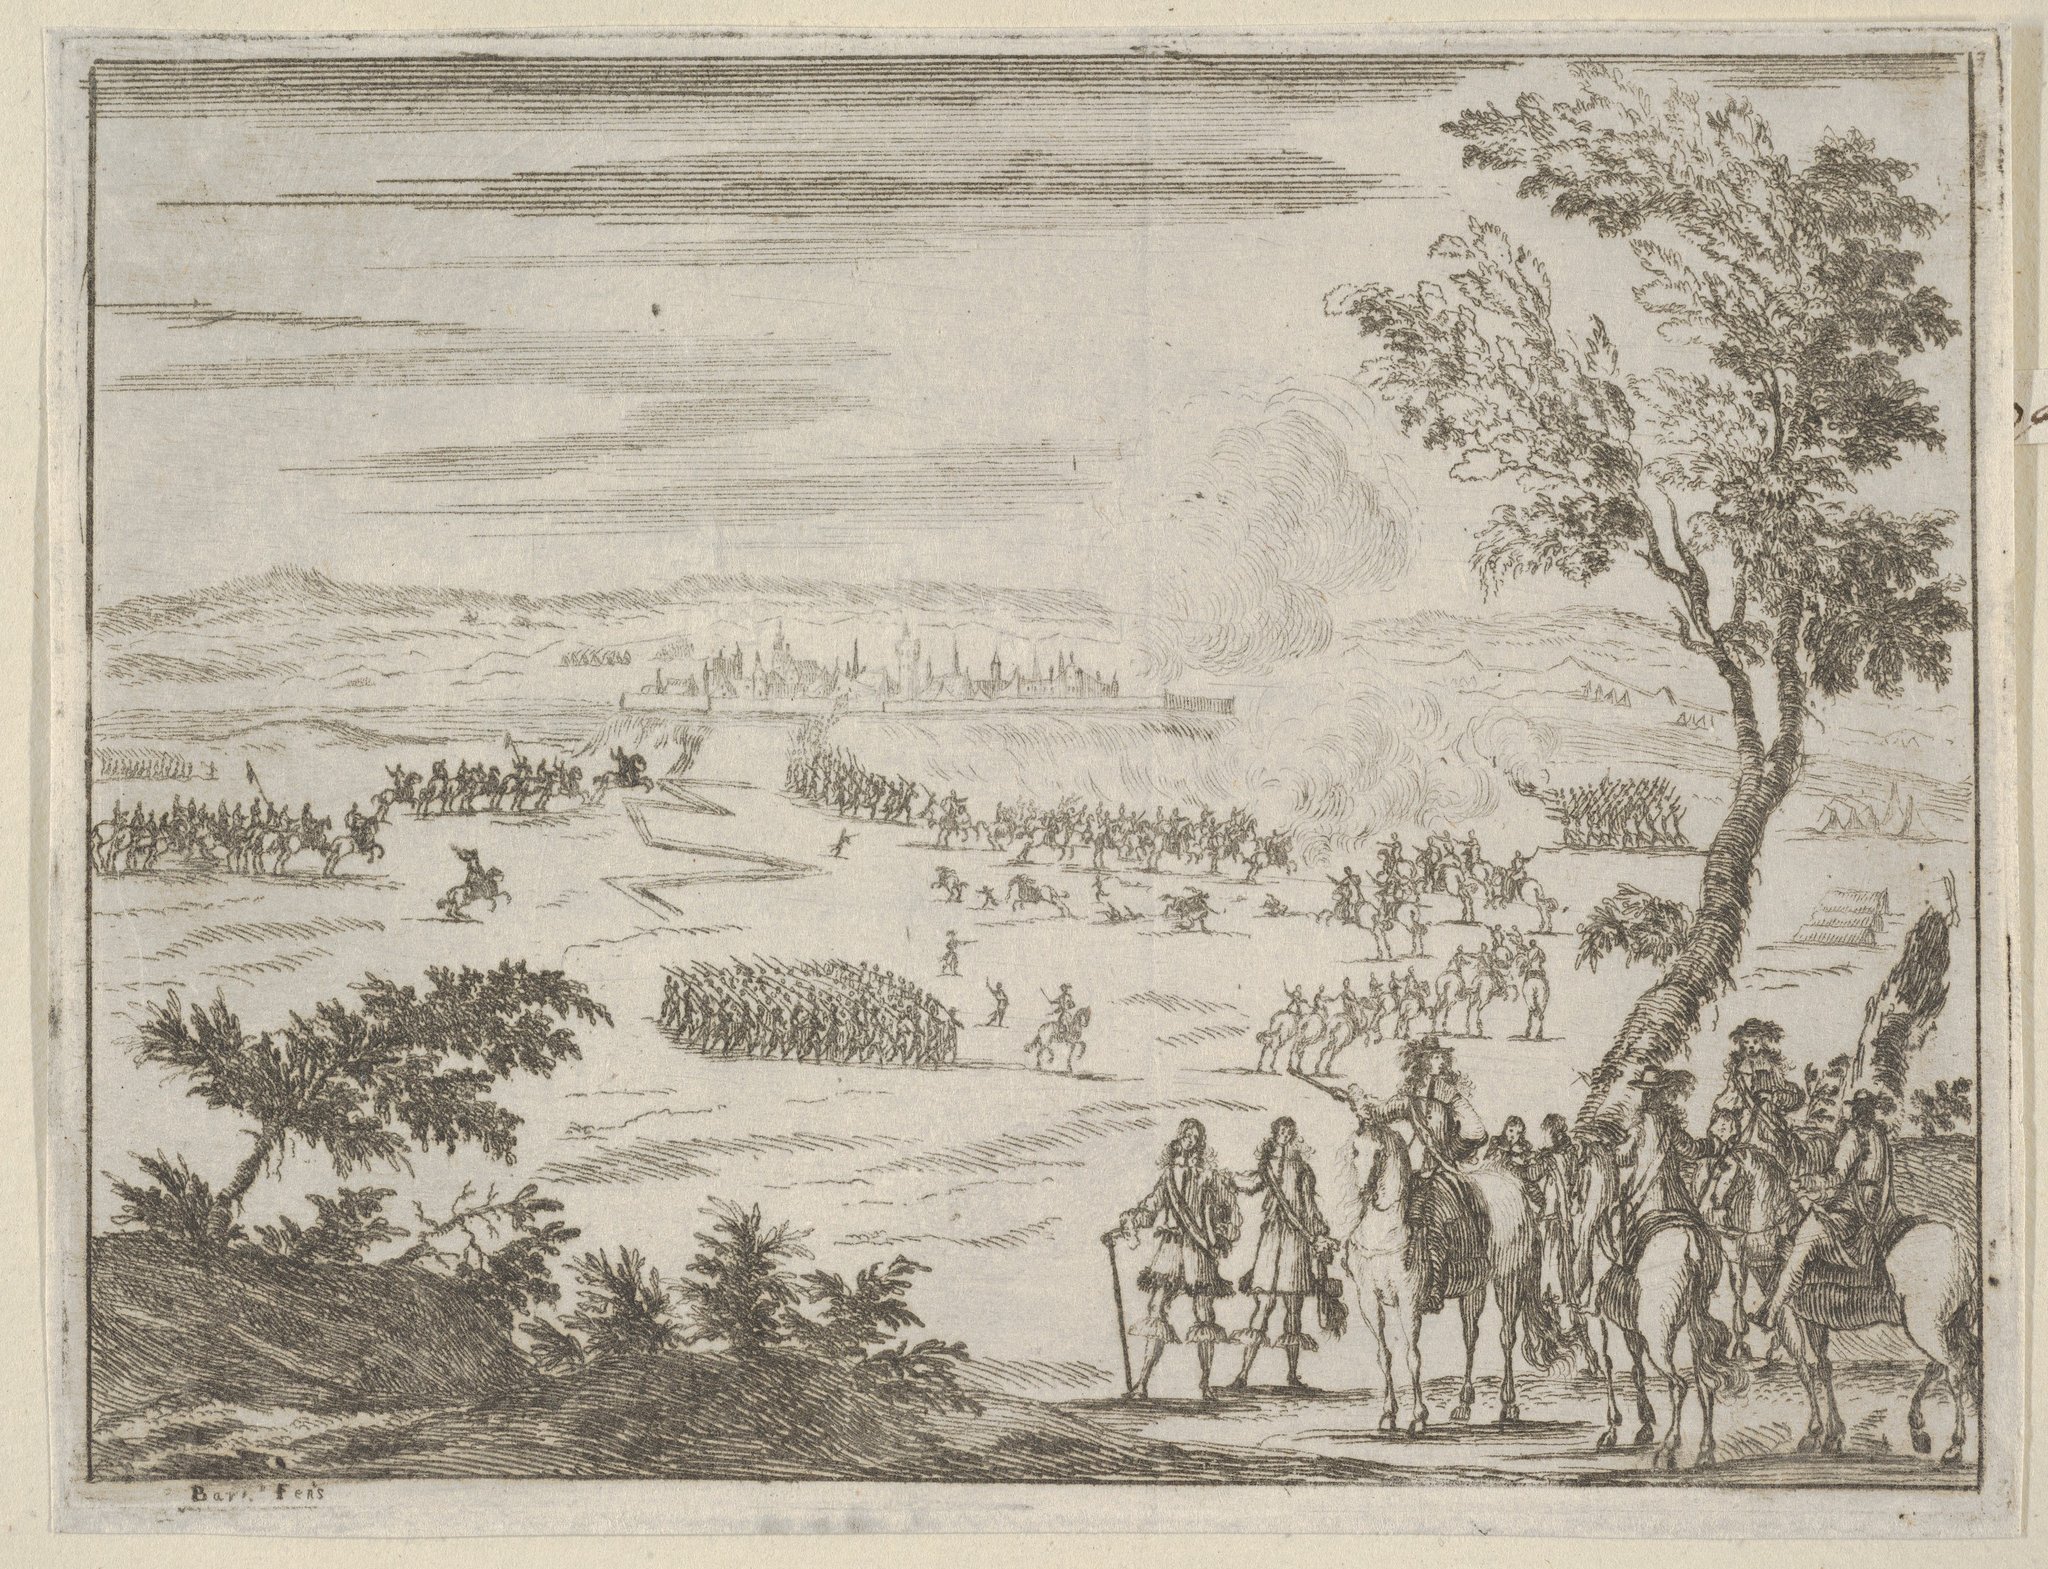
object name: print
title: Francesco I d'Este and the French Army Besiege Valenza, which has Been Taken by the Spanish, and by Persisting with Intrepid Courage, Succeeds in the Endeavor, from "L'Idea di un Principe ed Eroe Cristiano in Francesco I d'Este, di Modena e Reggio Duca VIII [...]"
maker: bartolomeo fenice (fénis)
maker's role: artist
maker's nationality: italian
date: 1659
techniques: etching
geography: italy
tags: human figures,battles,army,horses,trees